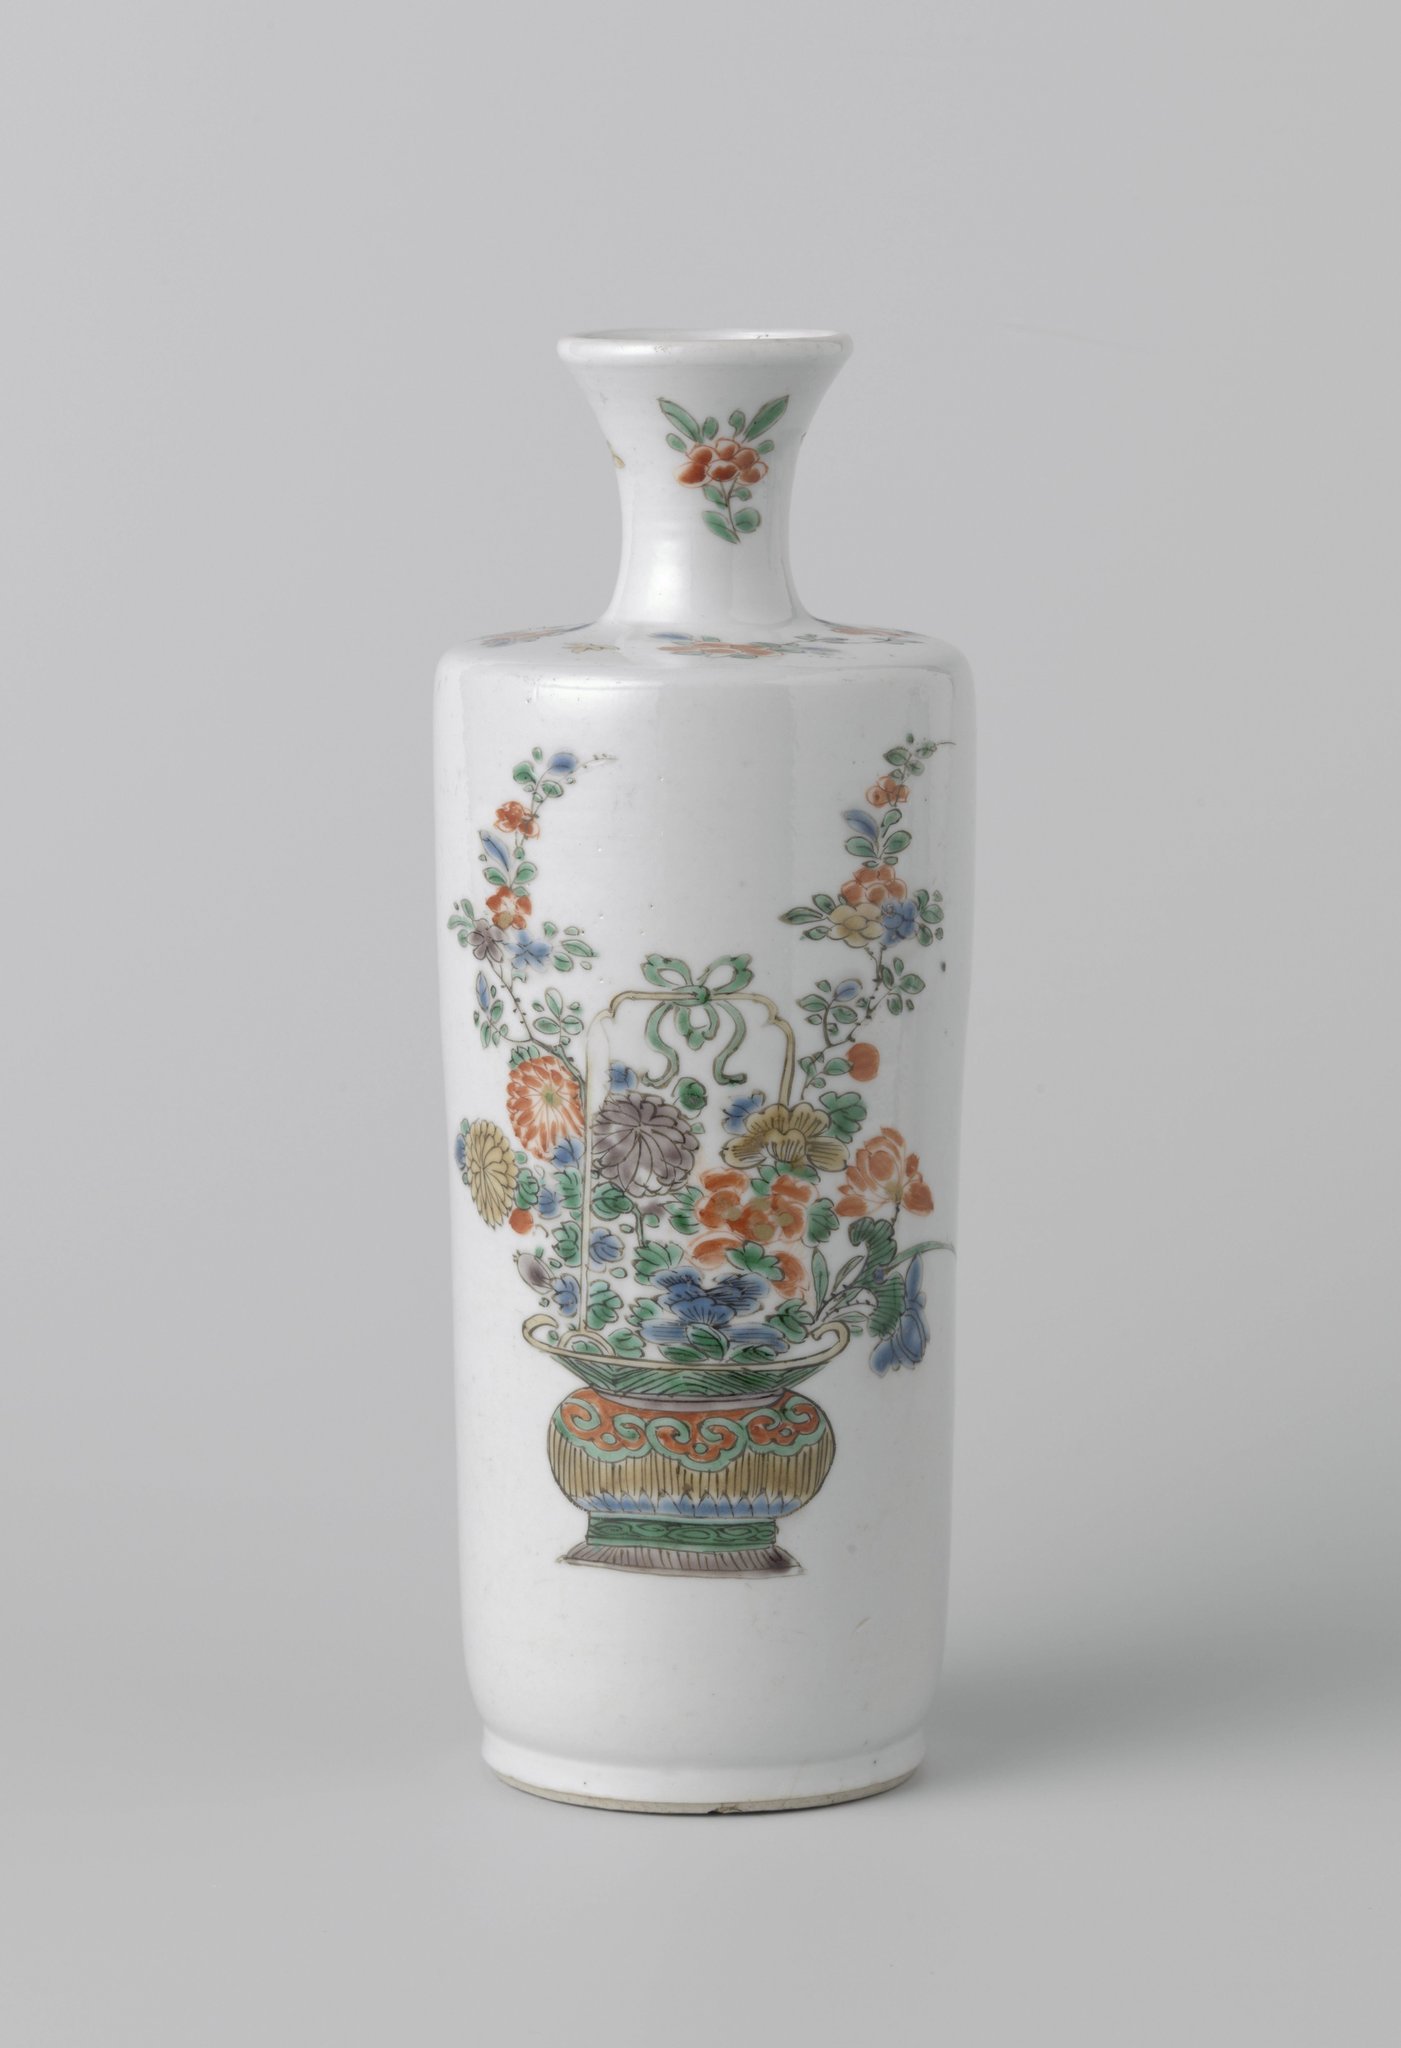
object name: vase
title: Cylindrical vase with flower baskets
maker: Anonymous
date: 1700-1724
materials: glaze, gold, paint, porcelain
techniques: firing, gilding, turning, vitrification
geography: china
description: AK-NM-6444 Twee kleine vazen • Famille verte porselein • Onderdeel van Royers porseleinverzameling Deze vazen hebben de typische vorm van de Chinese Kangxi roulrau-vaas – iets versmallend richting de voetring. De smalle trompetnek wijkt echter af. Bij een rouleau verwacht men een brede cilindrische nek met platte rand. Net als bij het vaasje AK-NM-6428 en de kom AK-NM-6403 is de voorstelling zonder compartimentering door decoratieve banden op het witte vlak geschilderd. Dit doet denken aan een albumblad met een bloemenmand. De bloemenmand met hengsel is een welbekend decoratie-element in de Kangxi-tijd (zie hiervoor ook AK-NM-6730). Een bak of vaas met bloeiende planten is in Kraakporselein en de Japanse navolgingen ervan heel gebruikelijk. Dit model bloemenman-met-hengsel is in die vroege periode nog zeldzaam. Een bordje uit de in 1600 gezonken San Diego is een vroeg voorbeeld van dit motief [Carré, Desroches en Goddio 1994, cat.nr. 126]. In blauw-wit Kangxi is het motief zeer gebruikelijk, hoewel de famille verte kleuren zich veel beter lenen voor de verbeelding van bloeiende planten. Het Rijksmuseum heeft een identiek vaasje afkomstig uit collectie van Robert May (1875-1961) (AK-RBK-15888). Bronnen : Dominique Carré, Jean-Paul Desroches en Franck Goddio, Le San Diego: un trésor sous la mer, Parijs, 1994.